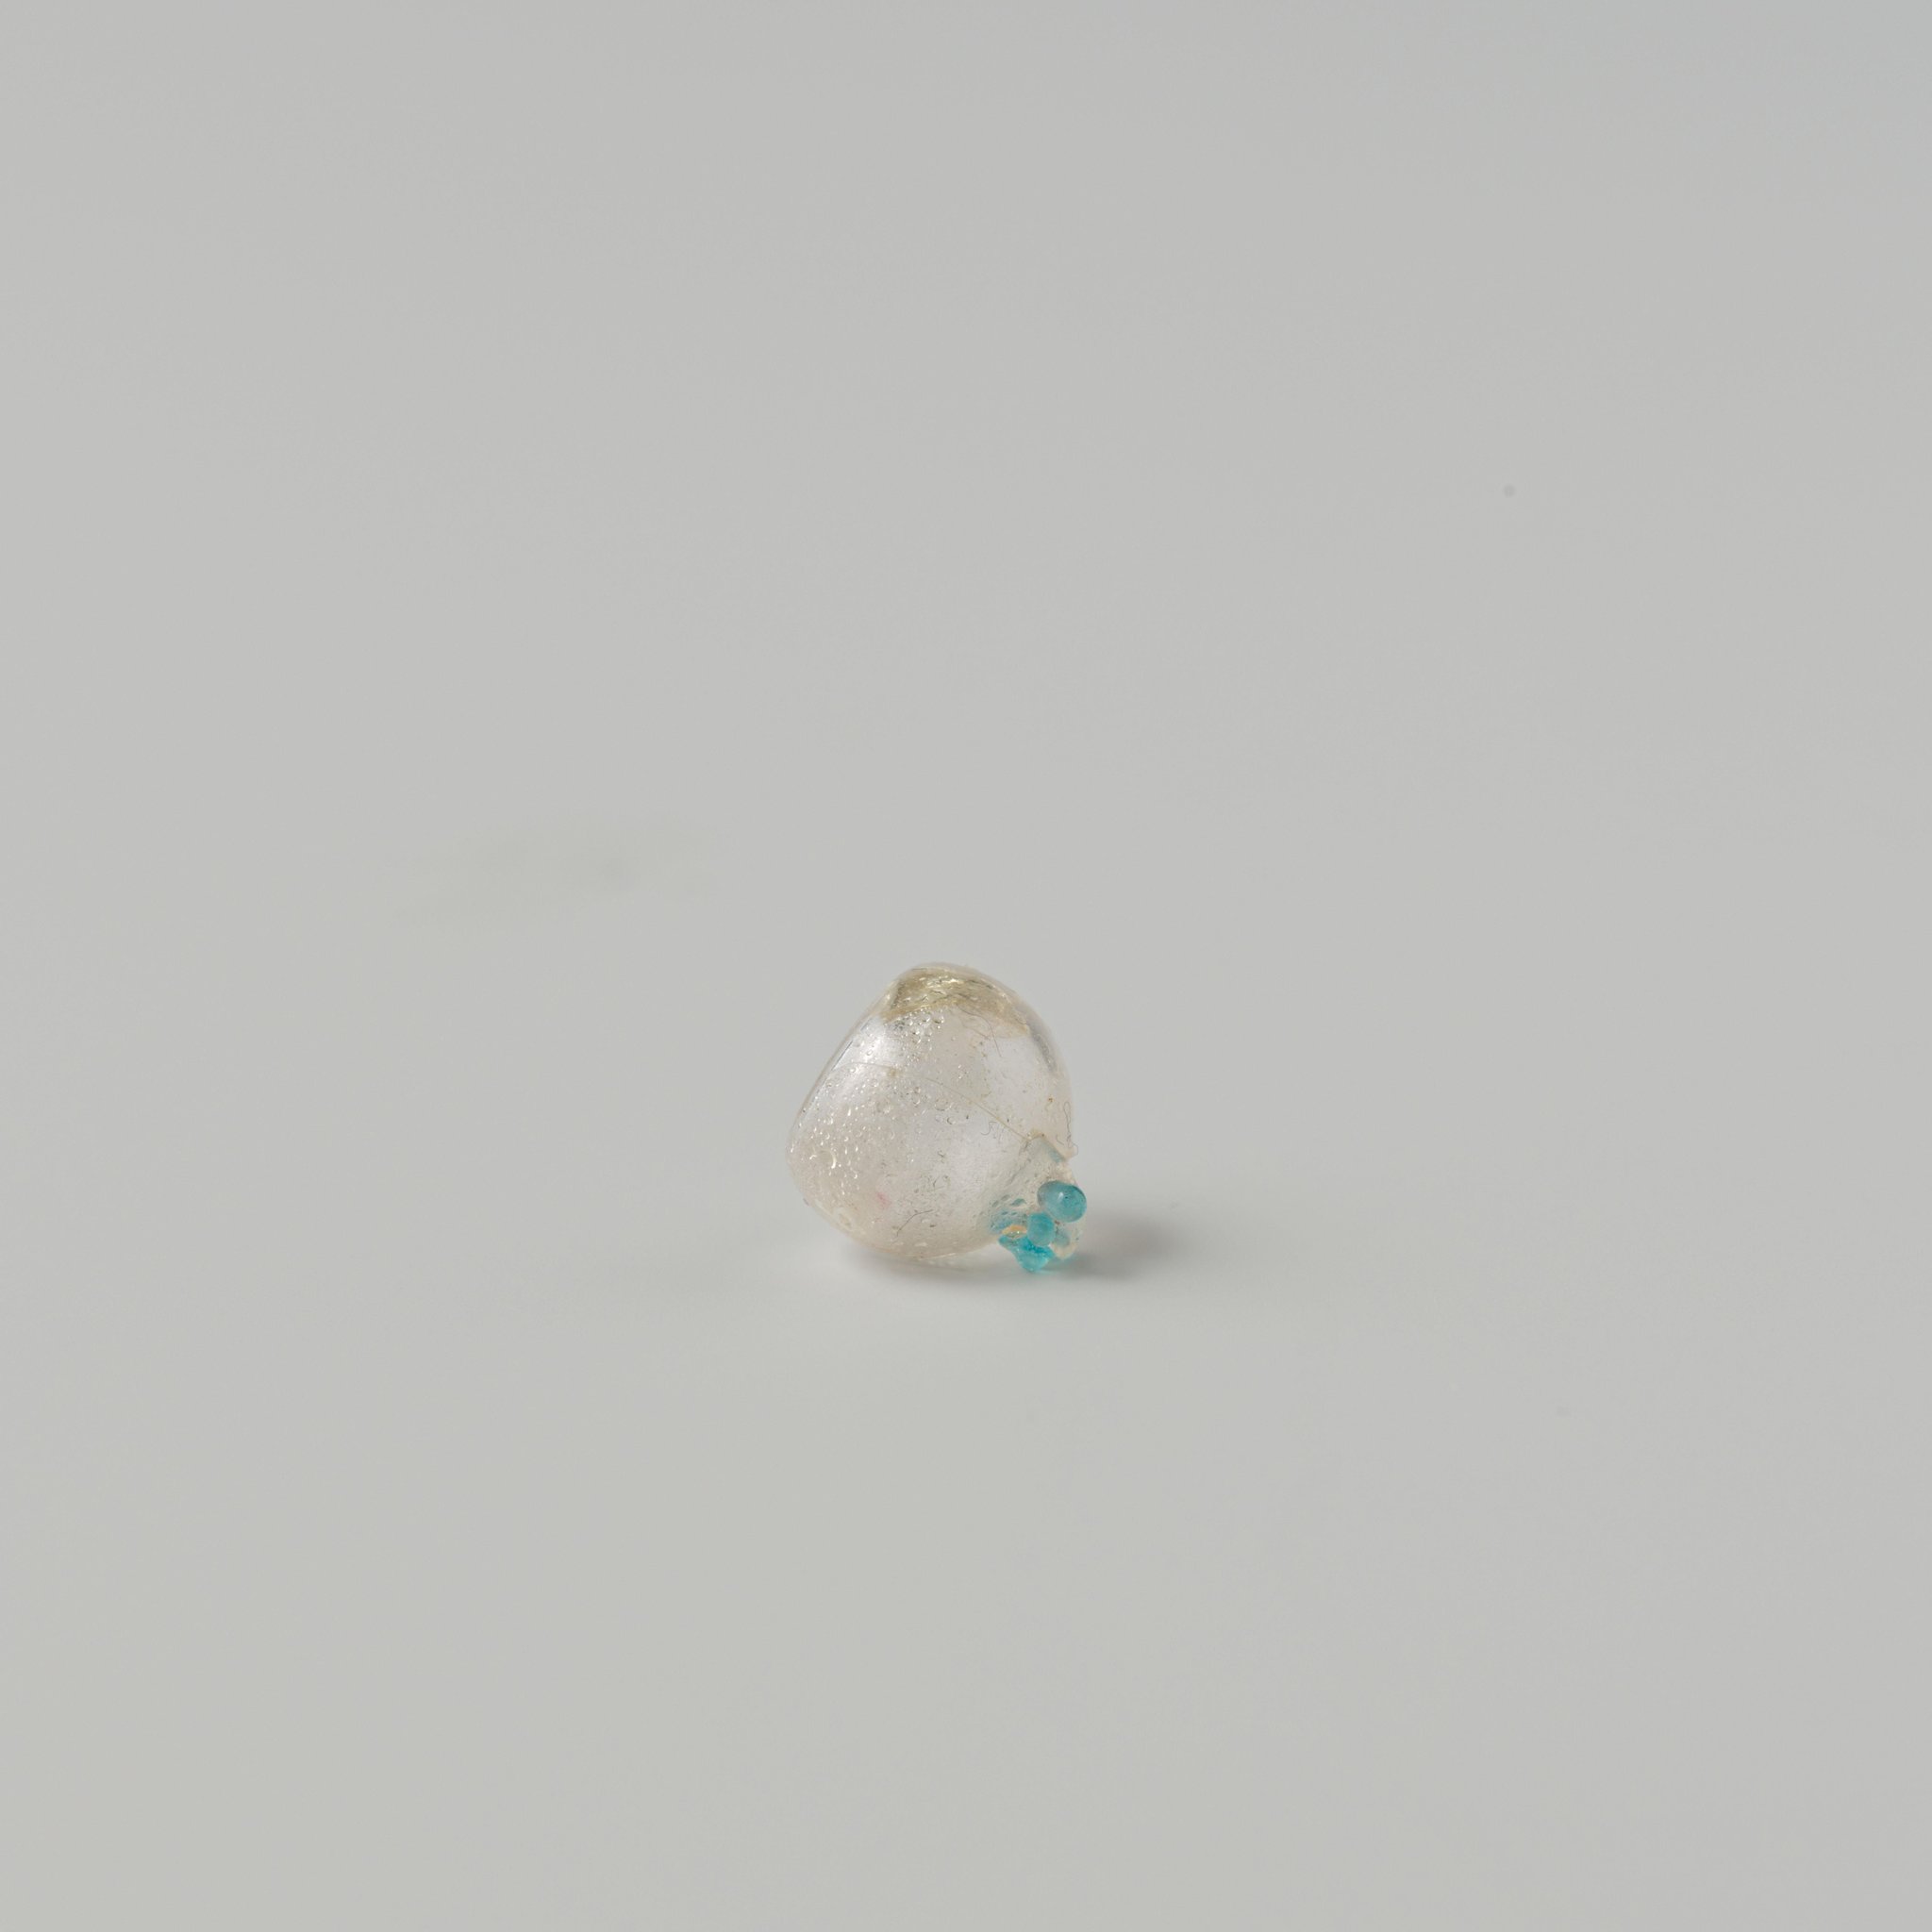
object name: miniature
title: Roemer van helder kleurloos glas met blauwe noppen op de schacht; cuppa dubbelwandig; deel van voet een schacht ontbreekt.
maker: Anonymous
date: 1675-1710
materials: glass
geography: amsterdam